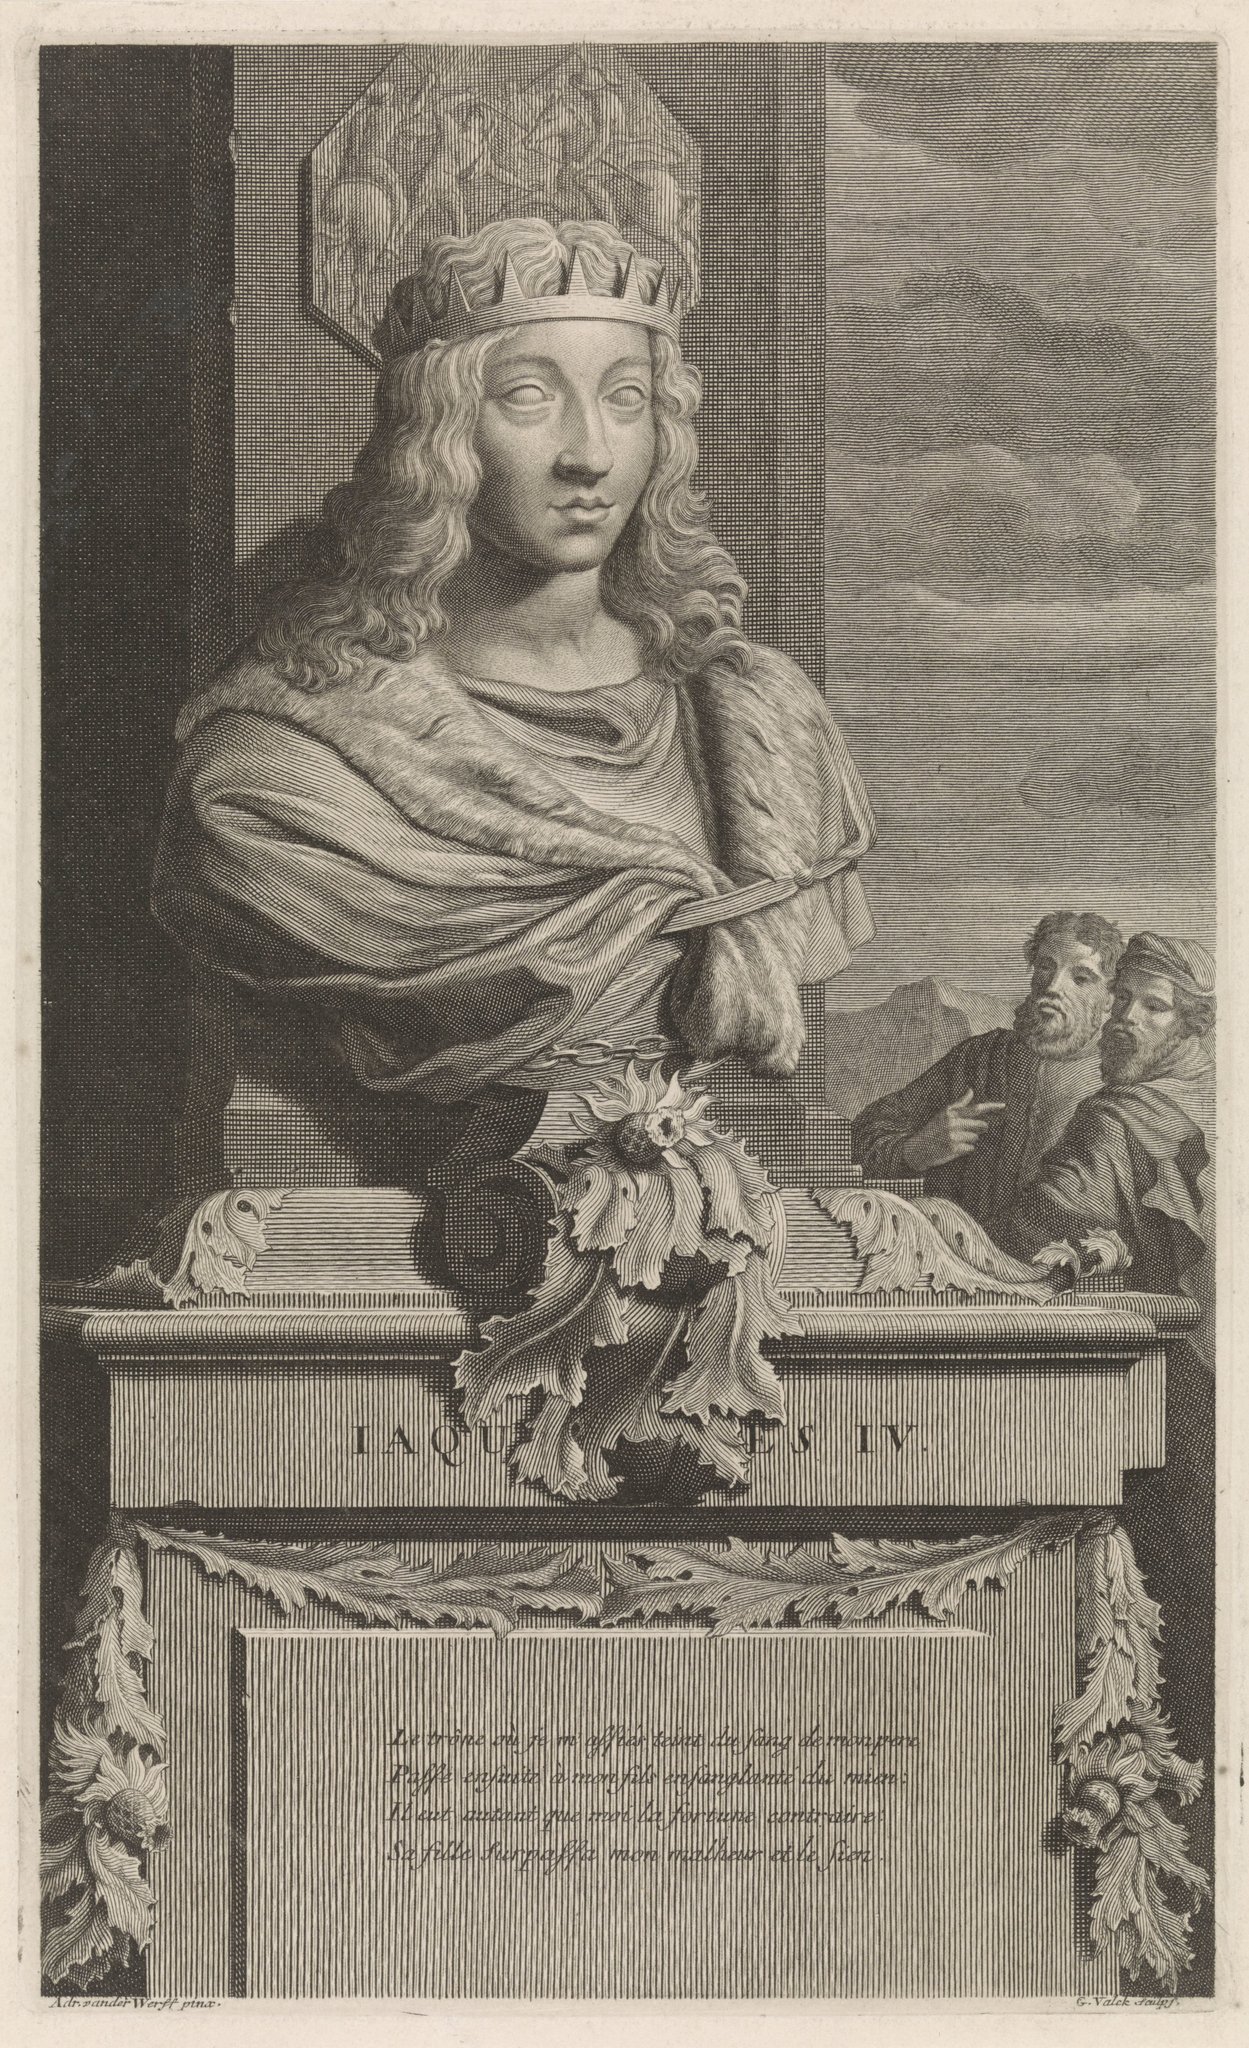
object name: print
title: Buste van Jacobus IV van Schotland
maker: adriaen van der werff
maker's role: draughtsman, painter, print maker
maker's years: 1659-1722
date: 1697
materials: paper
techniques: engraving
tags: piece of sculpture, reproduction of a piece of sculpture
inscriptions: collector's mark: Lugt 2760, collector's mark: Lugt 2228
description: Prent ook gebruikt als boekillustratie in: Larrey, Isaac de. Histoire d'Angleterre, d'Ecosse, et d'Irlande. Rotterdam: Reinier Leers, 1697.